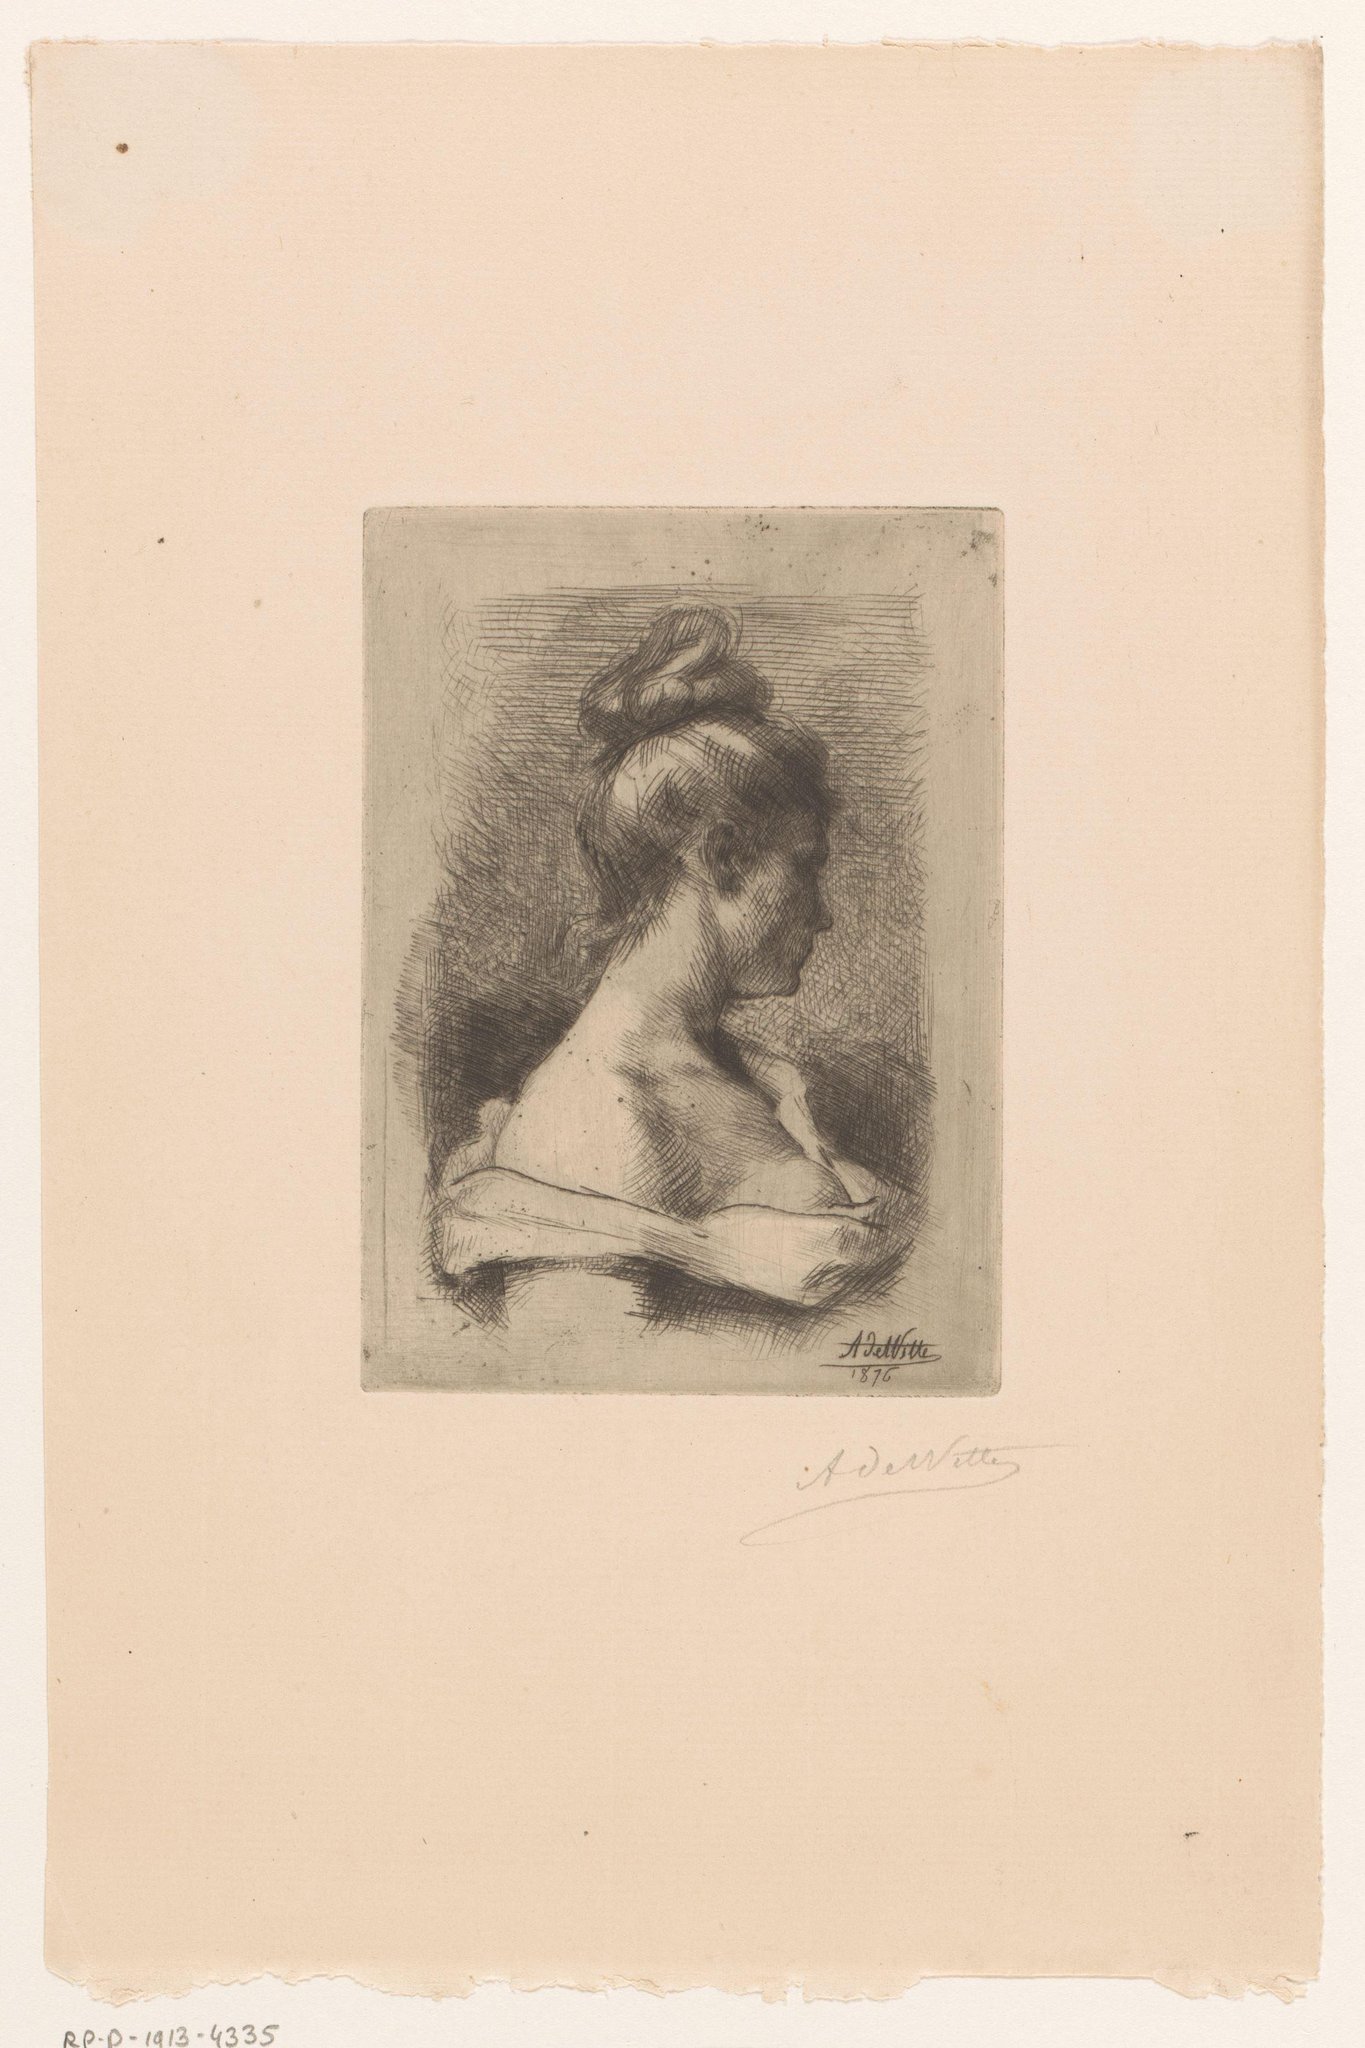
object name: print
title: Borstbeeld van een jonge vrouw met hoog kapsel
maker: adrien de witte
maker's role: print maker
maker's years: 1850-1935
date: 1876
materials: paper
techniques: drypoint, etching, intaglio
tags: adult woman, styles of hairdress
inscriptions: collector's mark: Lugt 2228